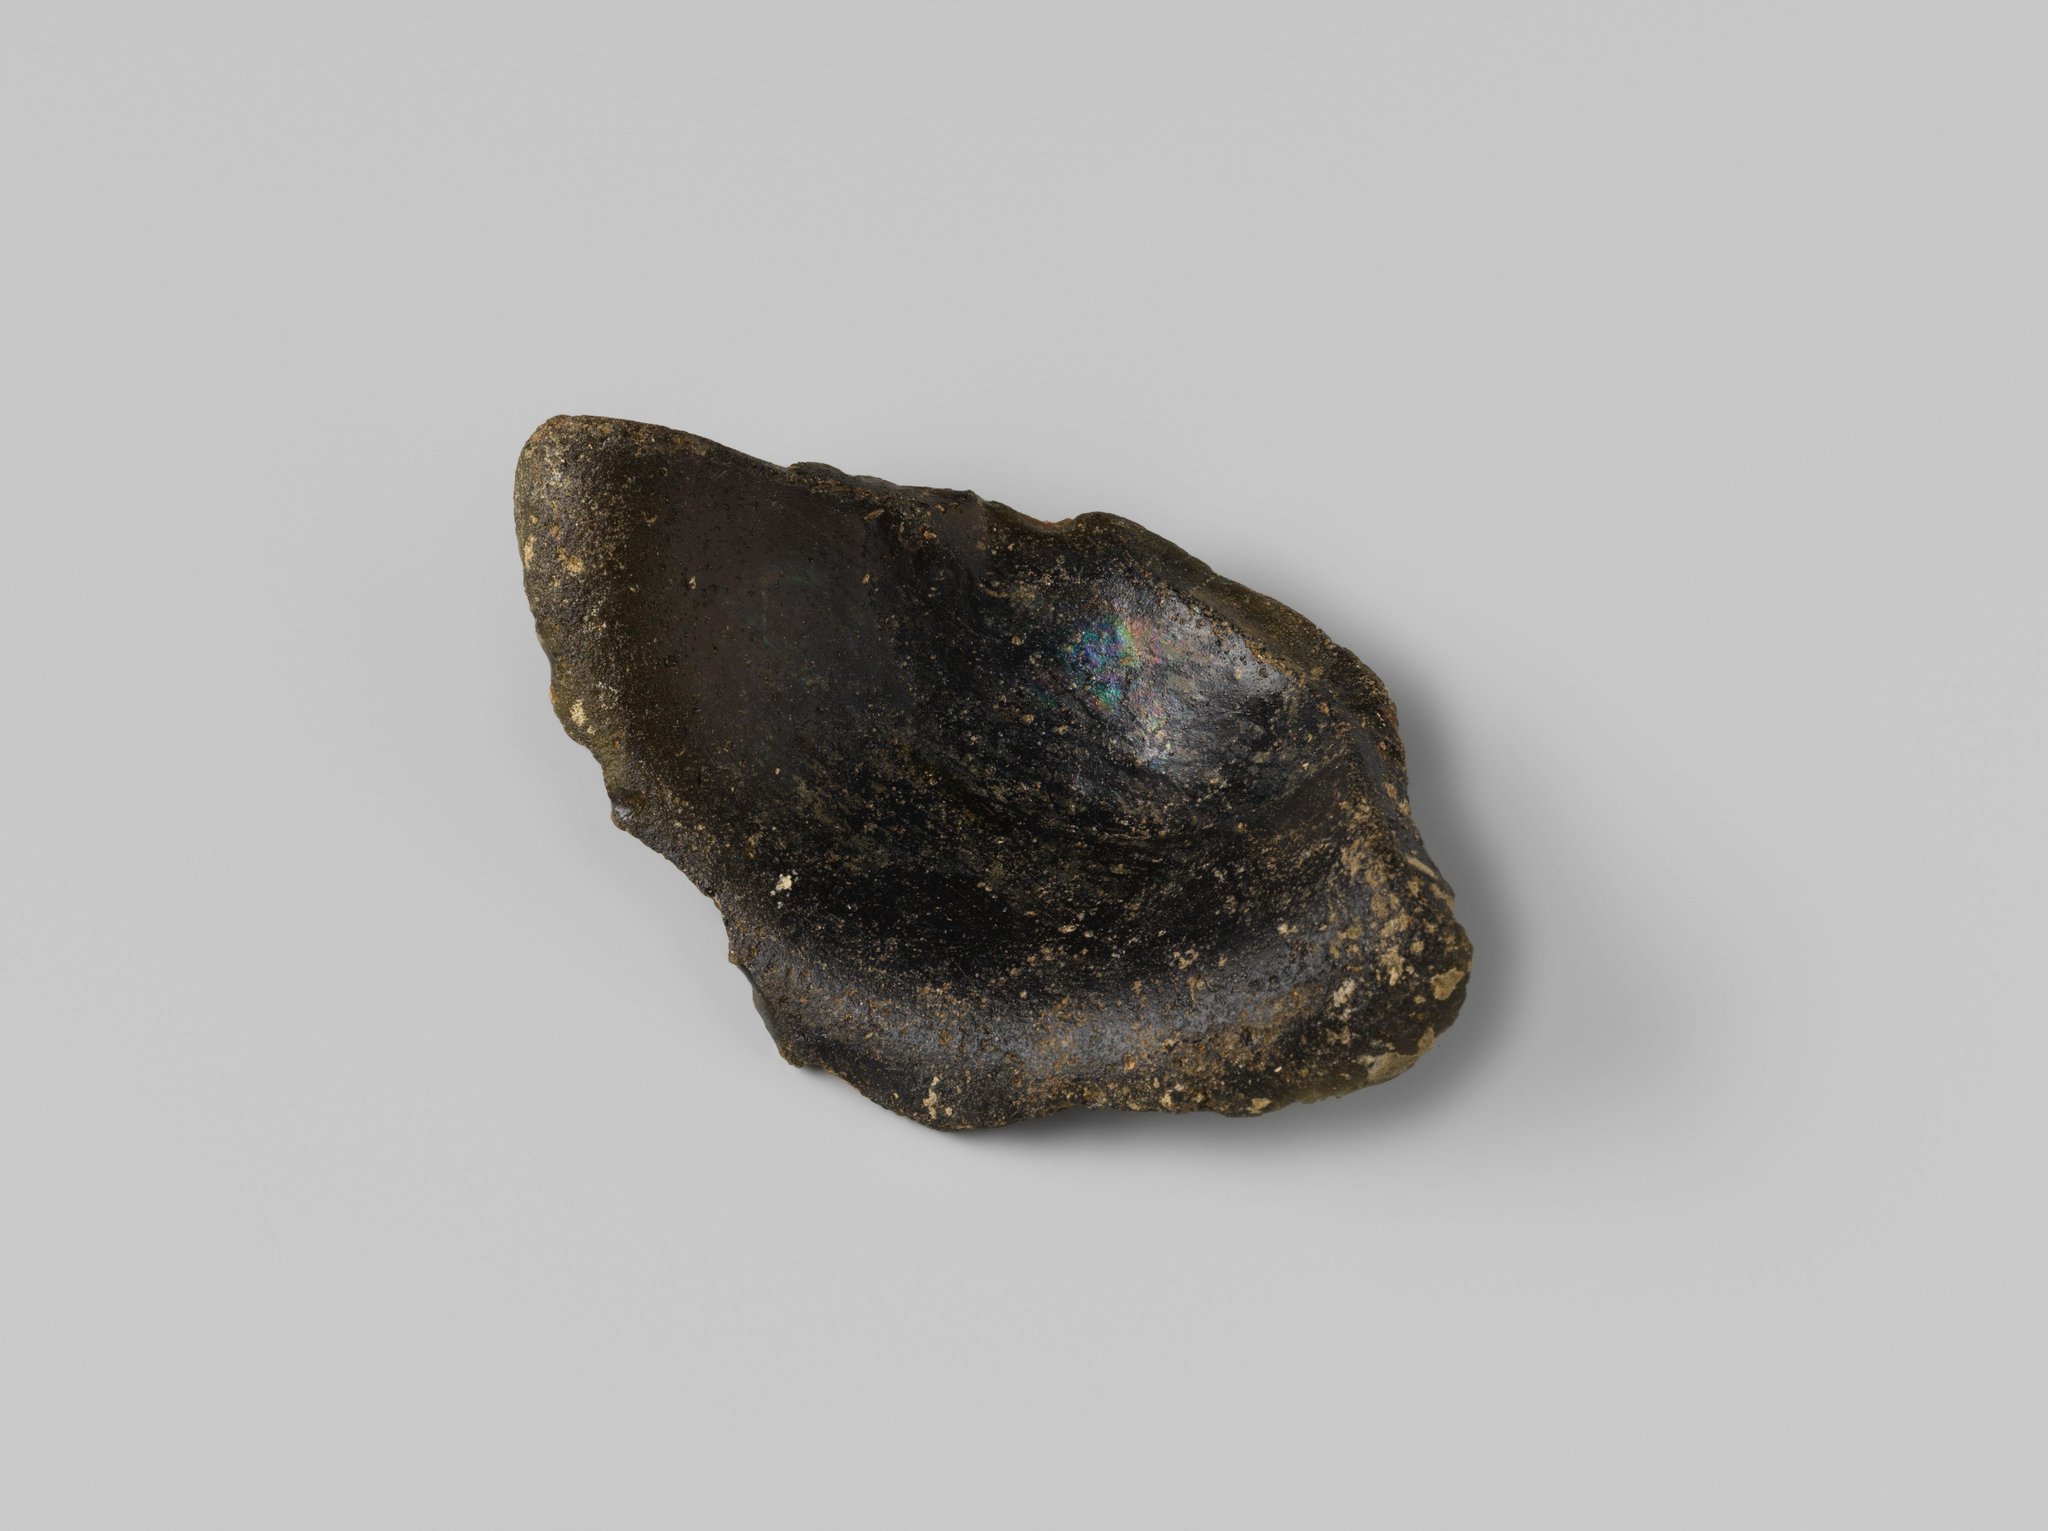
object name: sherd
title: Scherf van een wijnfles uit het wrak van de Oostindiëvaarder Hollandia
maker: Anonymous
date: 1700-1743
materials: glass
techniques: green glass